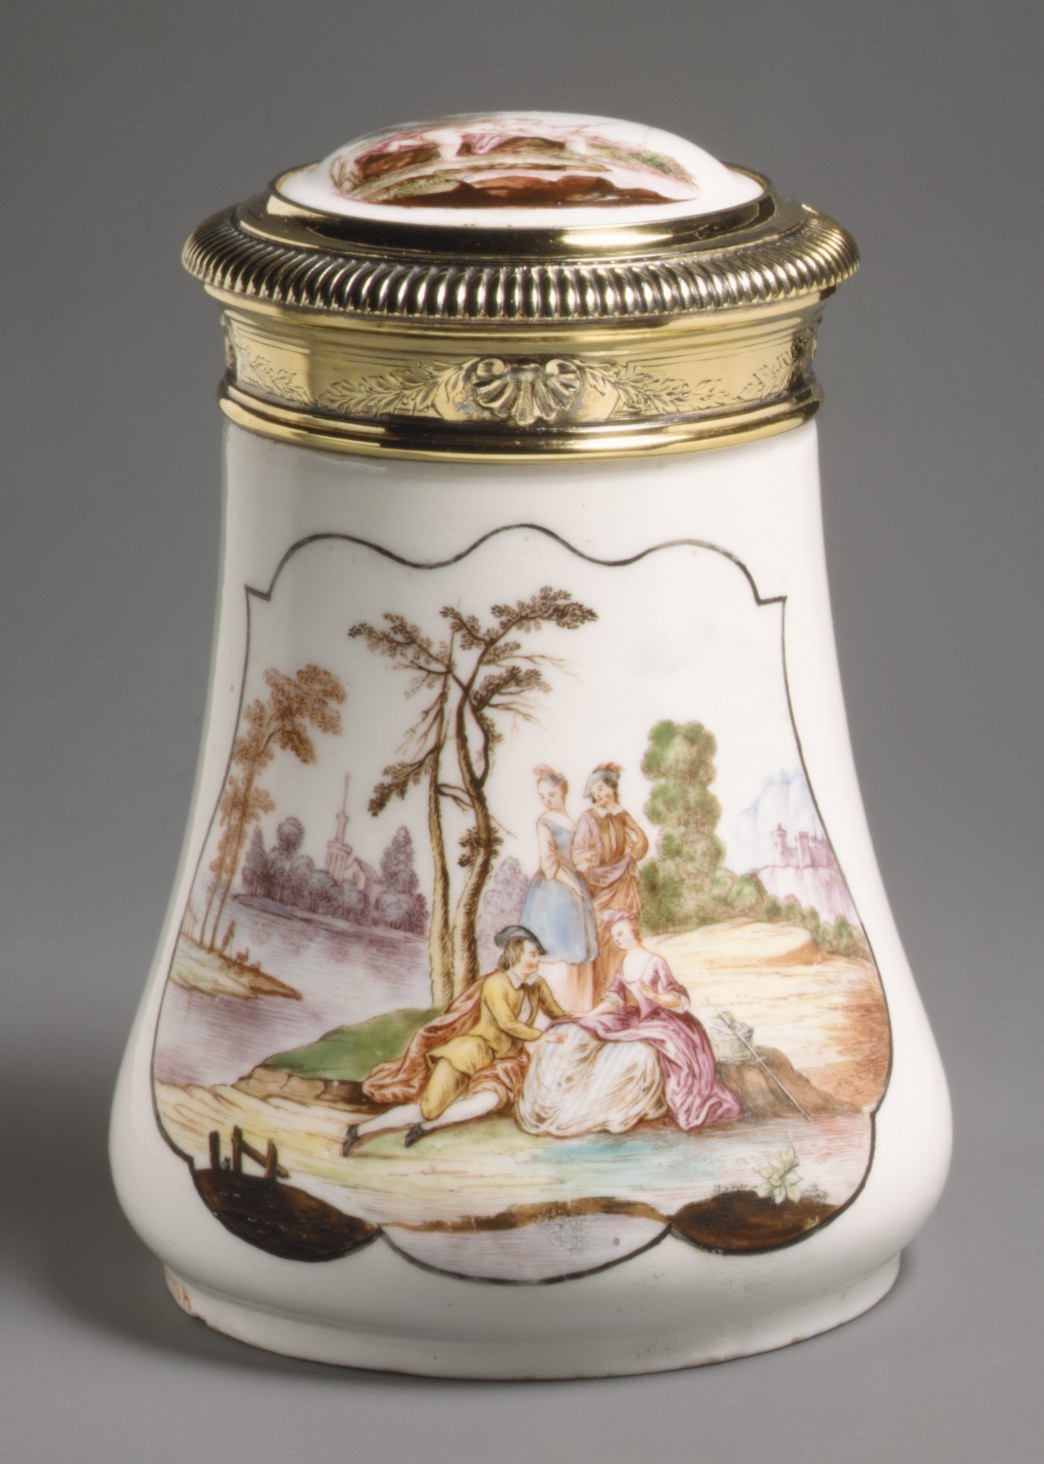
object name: caster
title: Caster (?)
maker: vincennes manufactory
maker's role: manufactory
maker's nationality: french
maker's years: 1740-1756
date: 1745-1750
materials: silver gilt, soft paste porcelain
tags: men,women,landscapes,trees